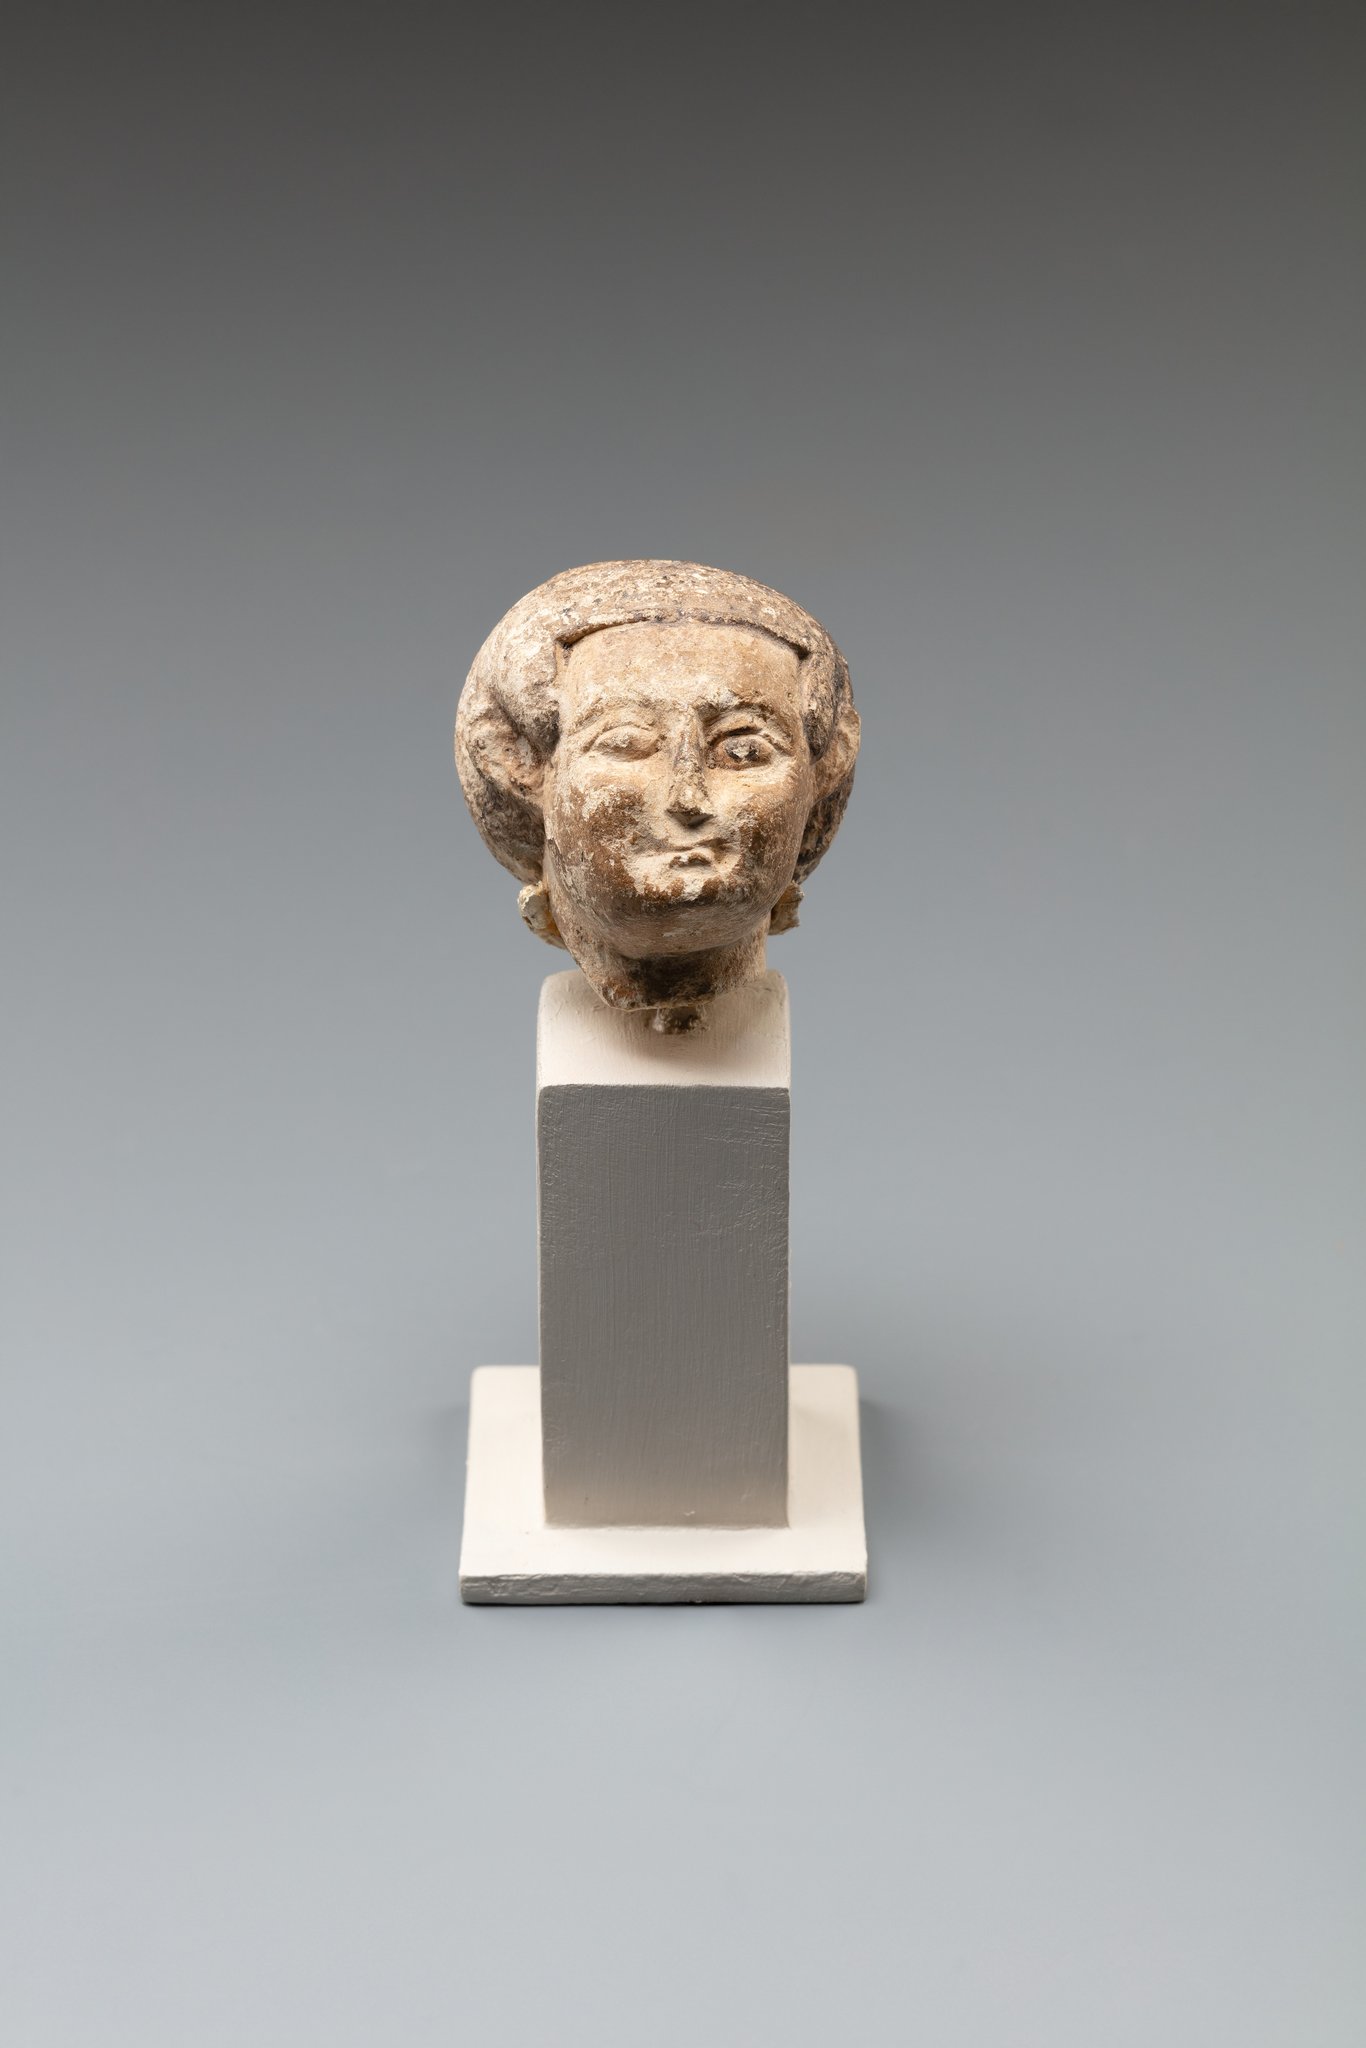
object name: head of a male figure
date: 1650-1550 BCE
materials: limestone, paint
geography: egypt